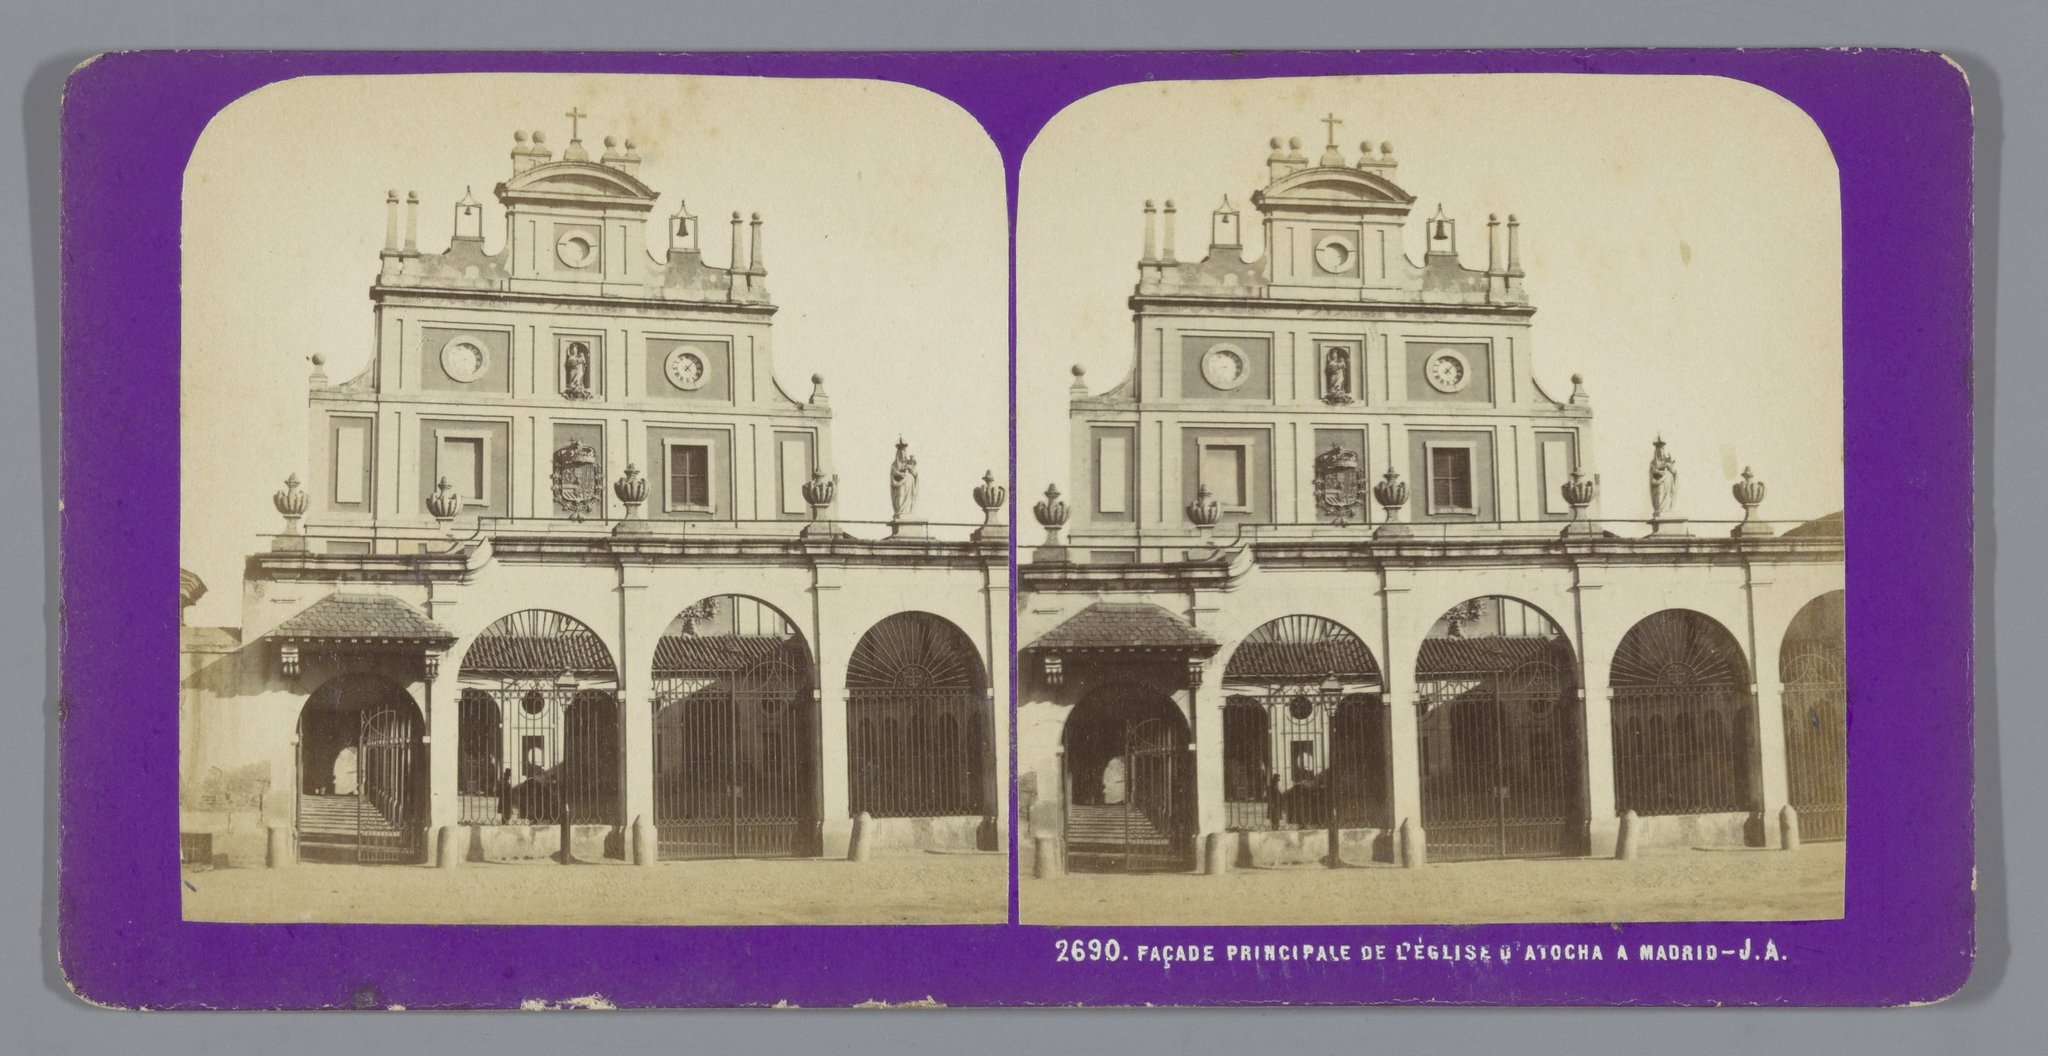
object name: stereograph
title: FAÇADE PRINCIPALE DE L'ÉGLISE A ATOCHA A MADRID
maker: jean andrieu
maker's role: fotograaf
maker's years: 1816-1872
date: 1862-1876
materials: cardboard, photographic support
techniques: albumen print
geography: madrid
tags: church (exterior), façade (of house or building)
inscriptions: number: ‘2690.’